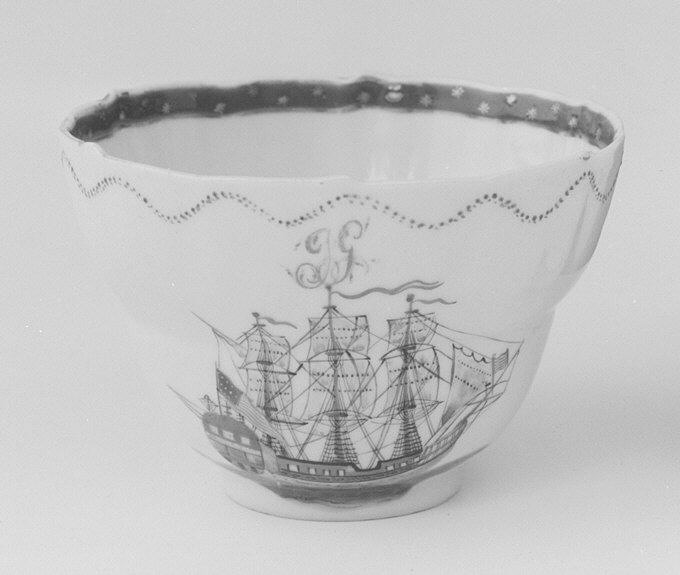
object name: cup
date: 1795-1800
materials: hard paste porcelain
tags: flags,insignia,ships